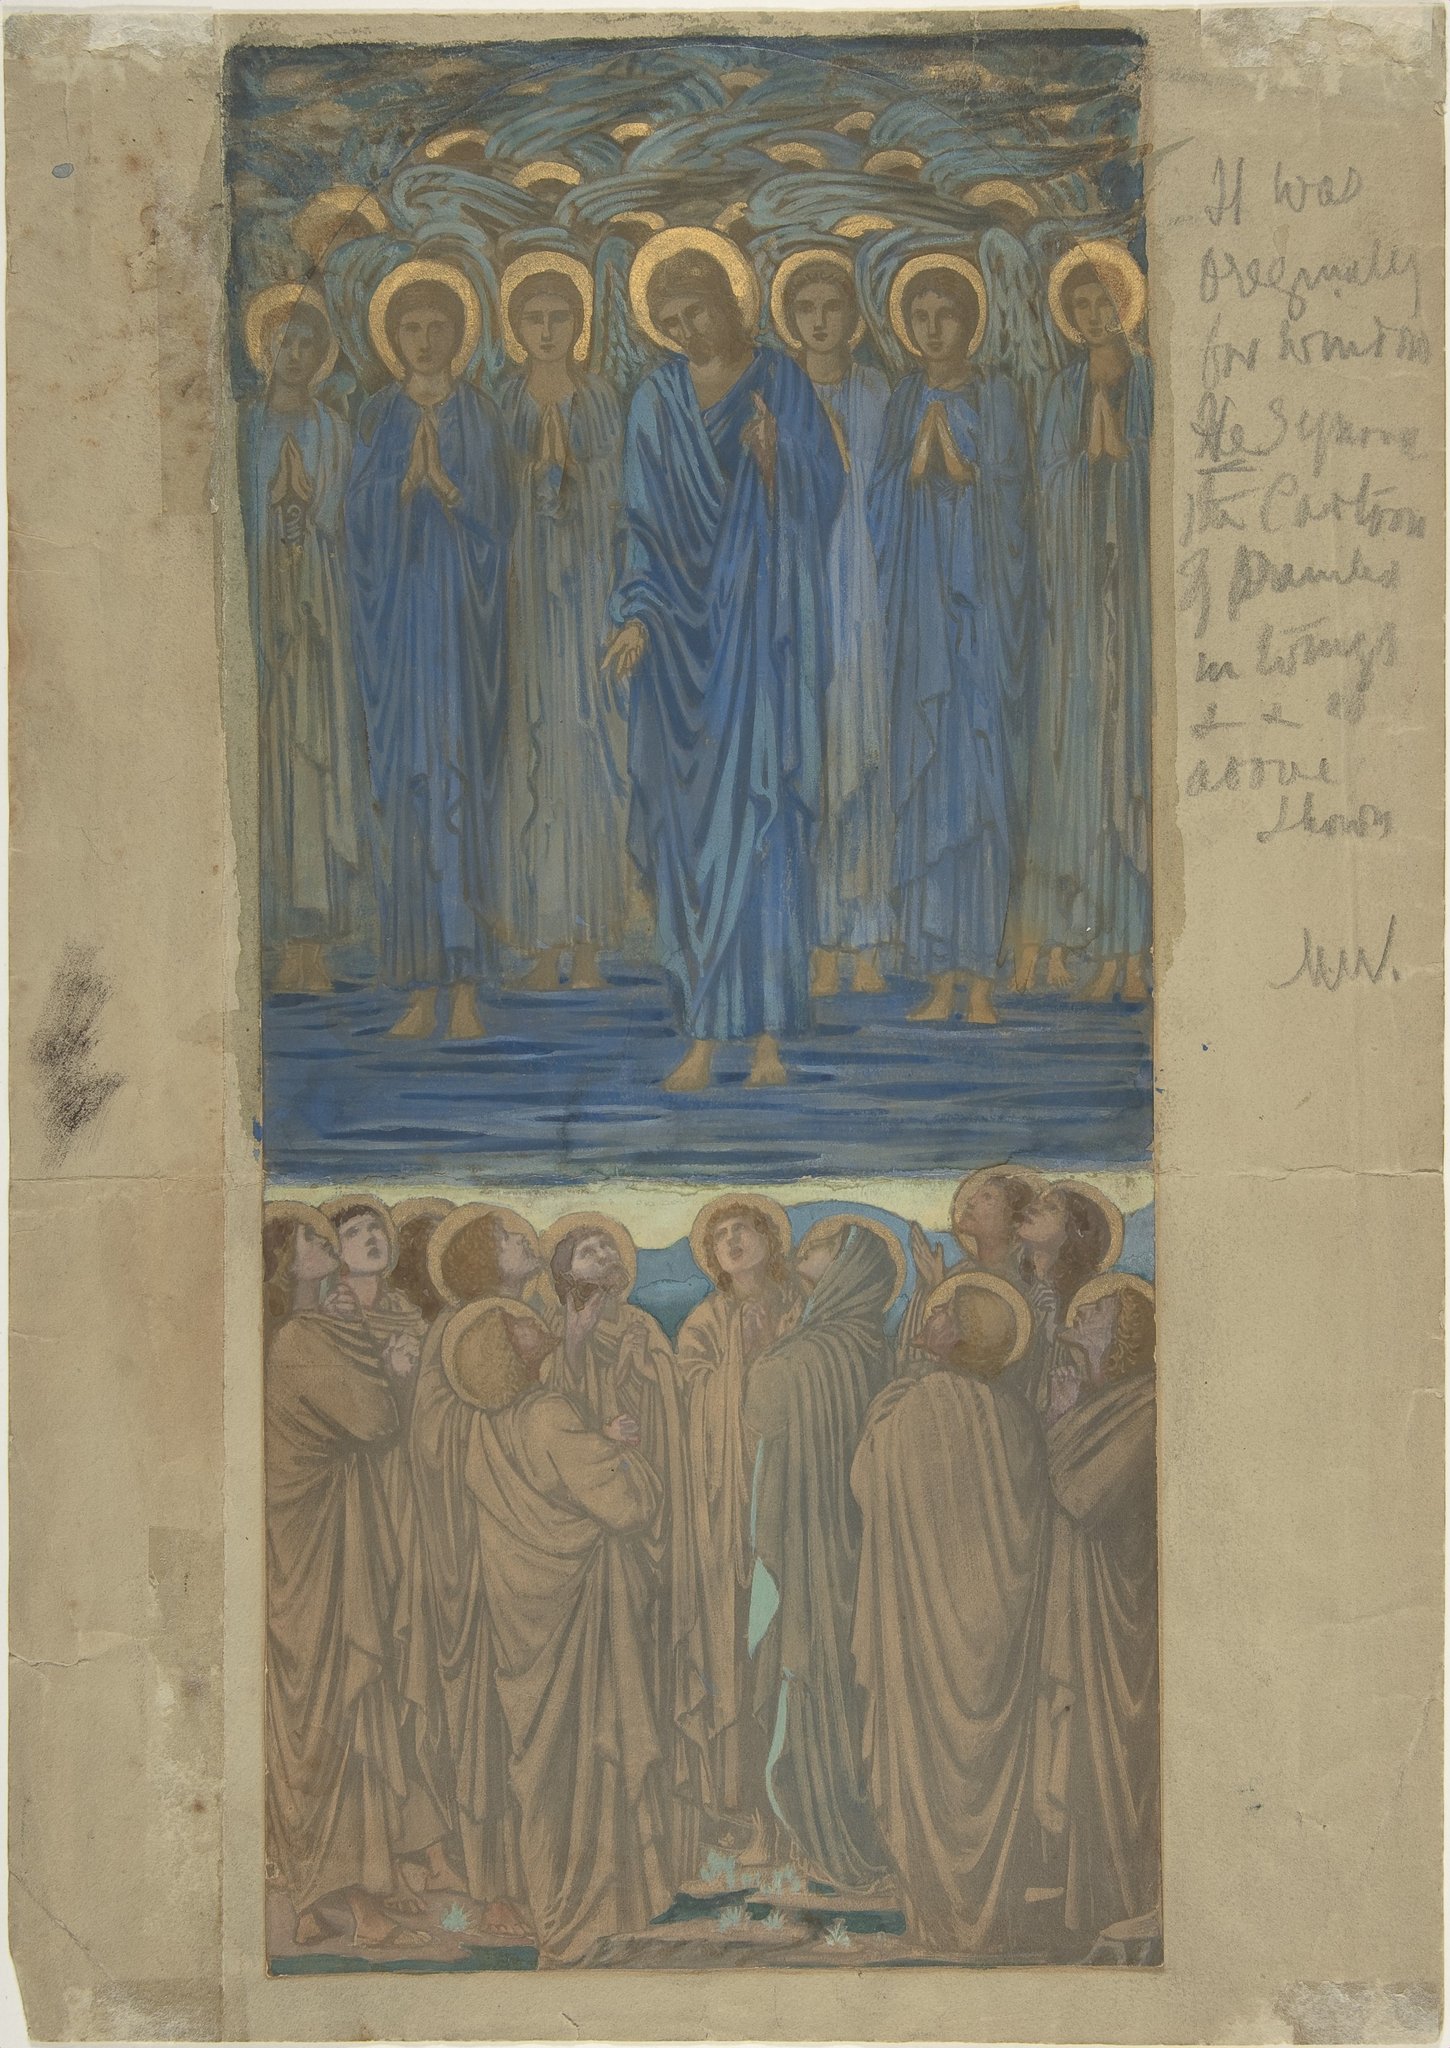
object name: drawing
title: Ascension of Christ (Acts I, 1–9): study for stained-glass window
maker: sir edward burne-jones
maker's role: artist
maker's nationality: british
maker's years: 1833-1898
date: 1875-1884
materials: gold paint, gouache, graphite, watercolor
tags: christ,saints